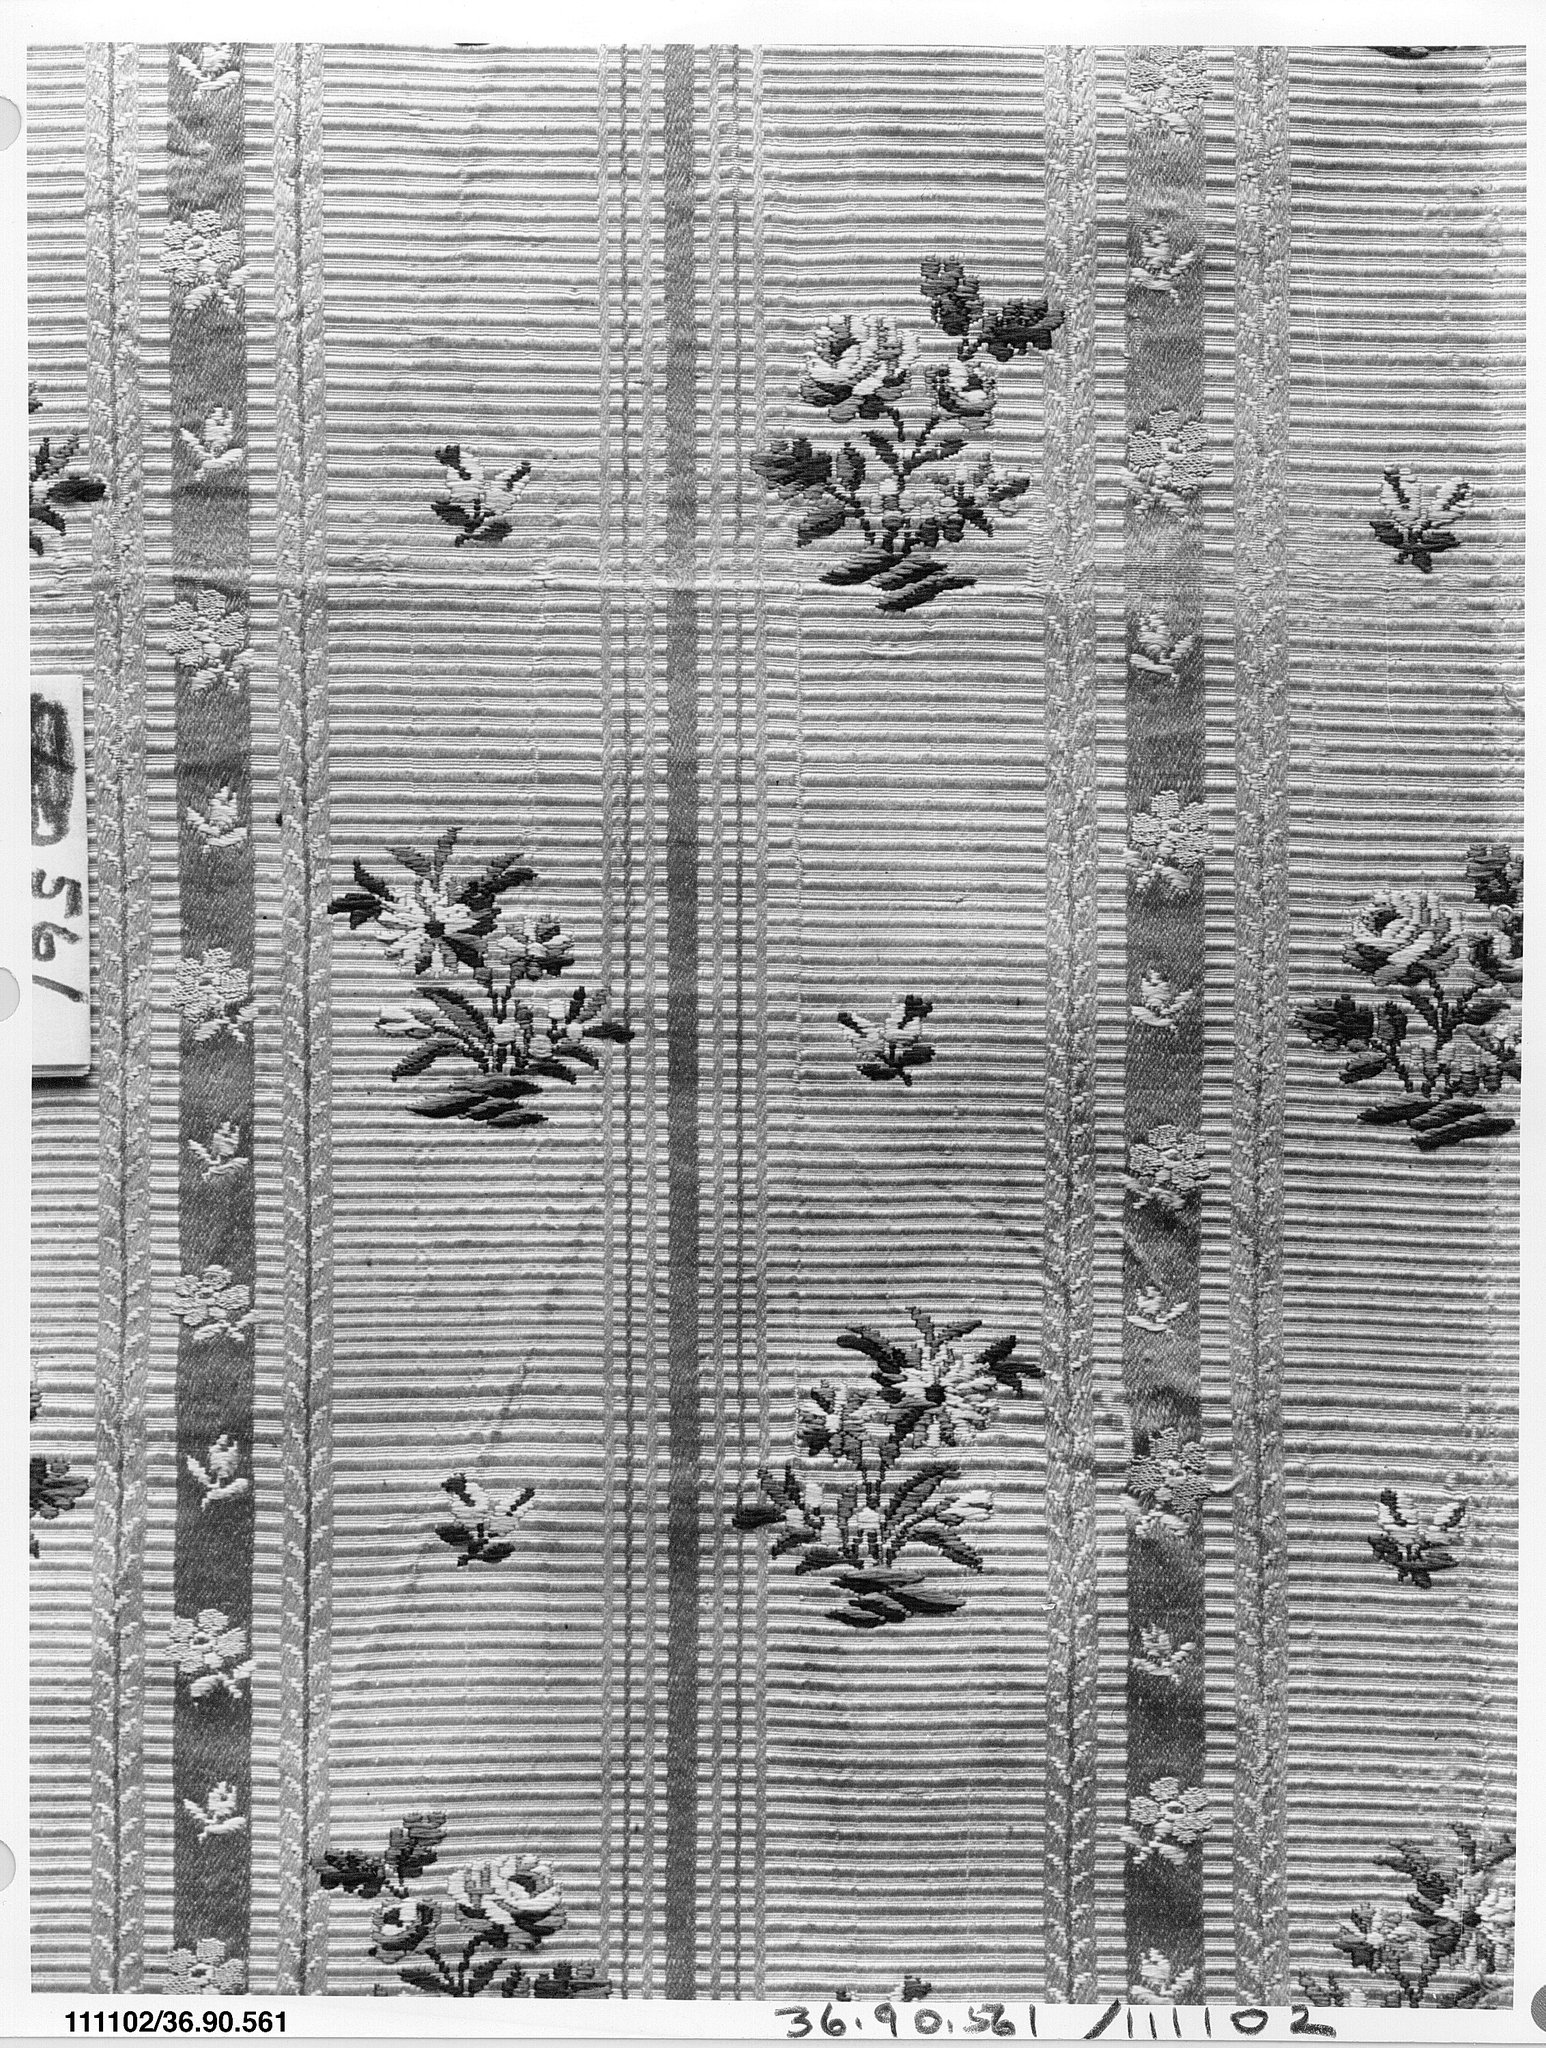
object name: piece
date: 1767-1800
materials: silk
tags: flowers,leaves